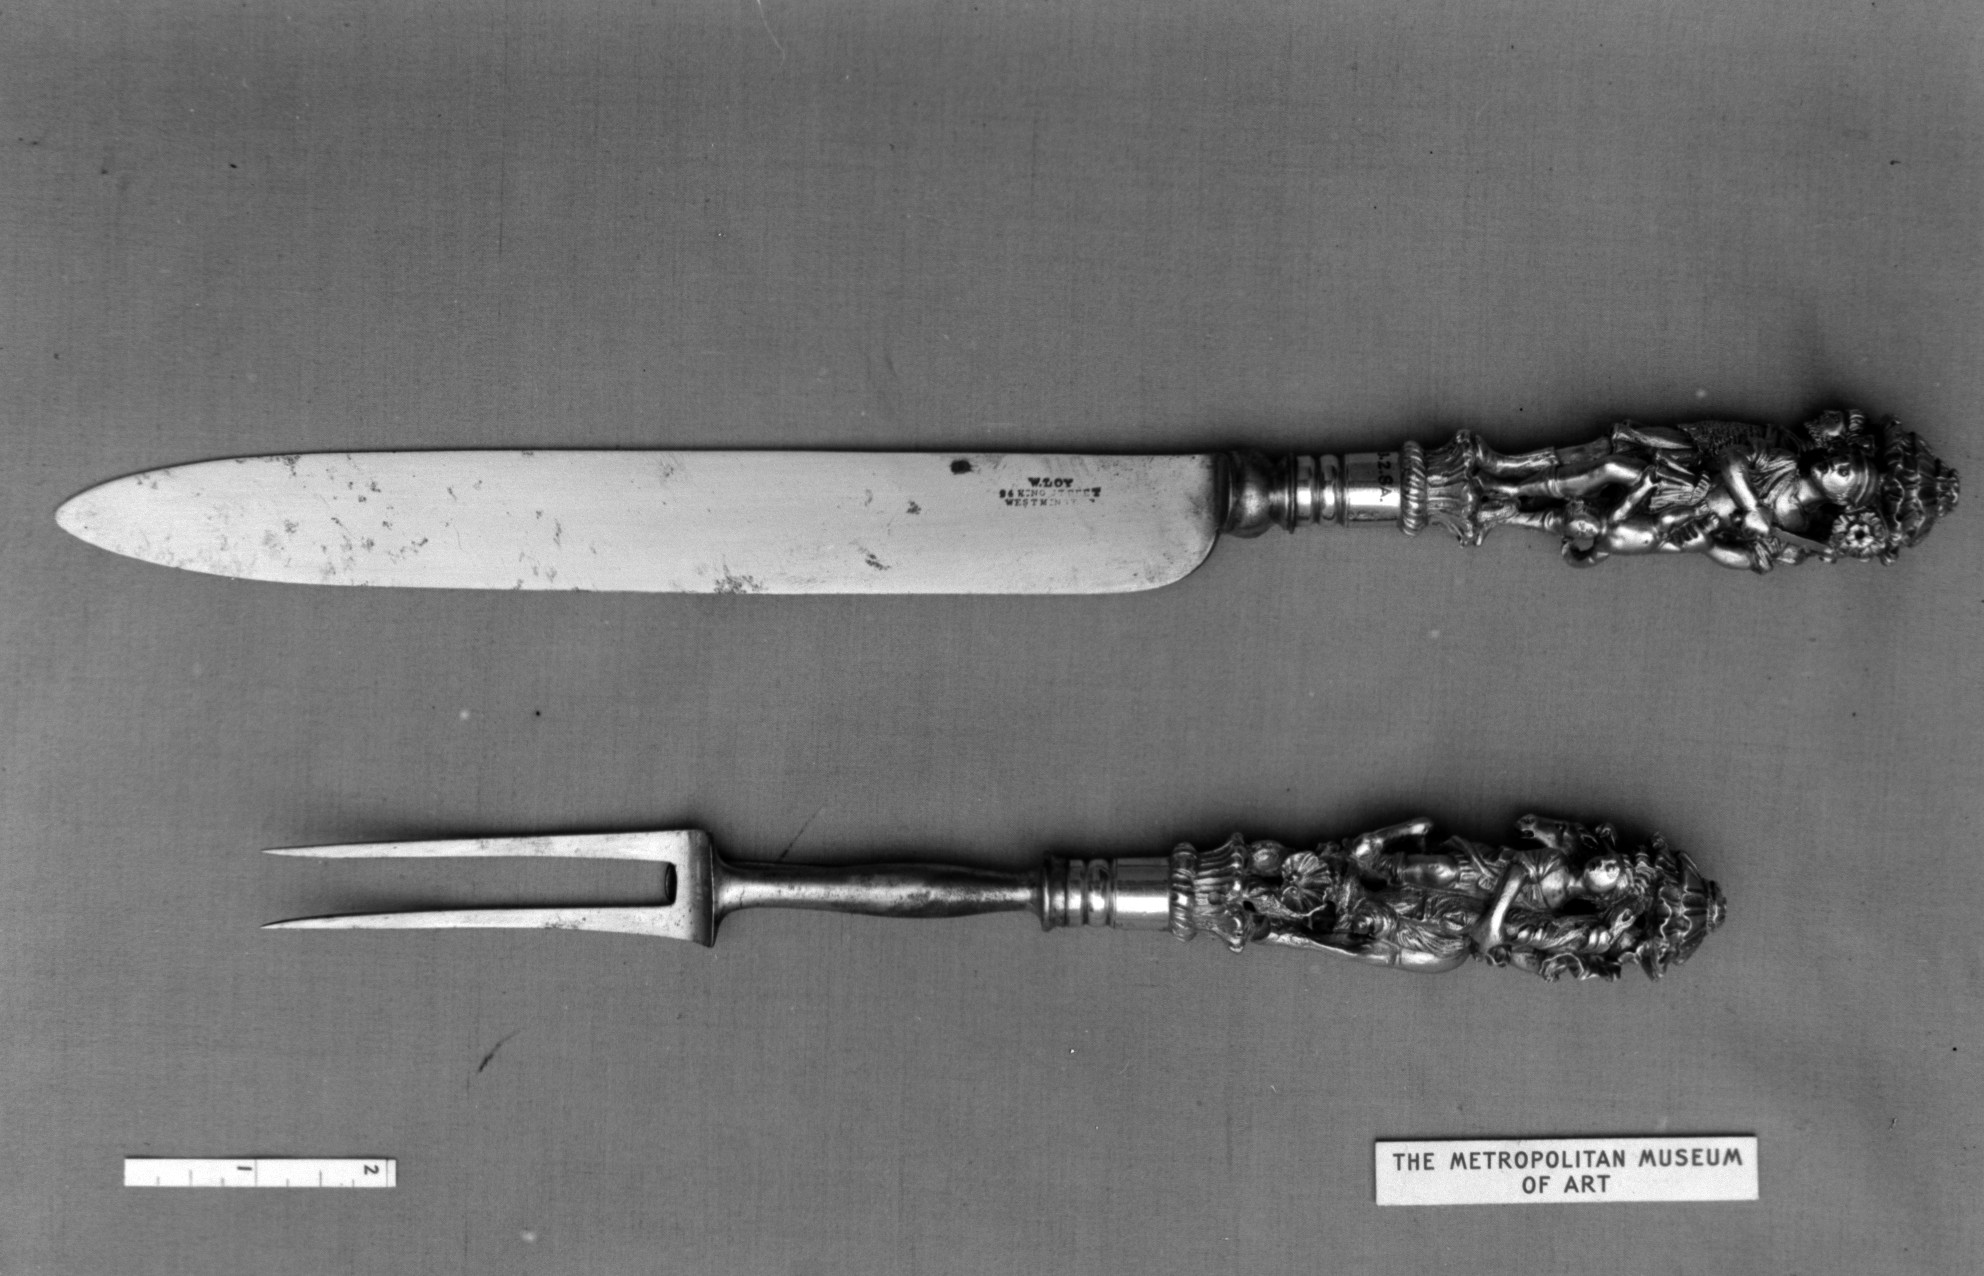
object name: knife and fork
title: Carving knife and fork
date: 1834-1866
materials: silver gilt, steel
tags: men